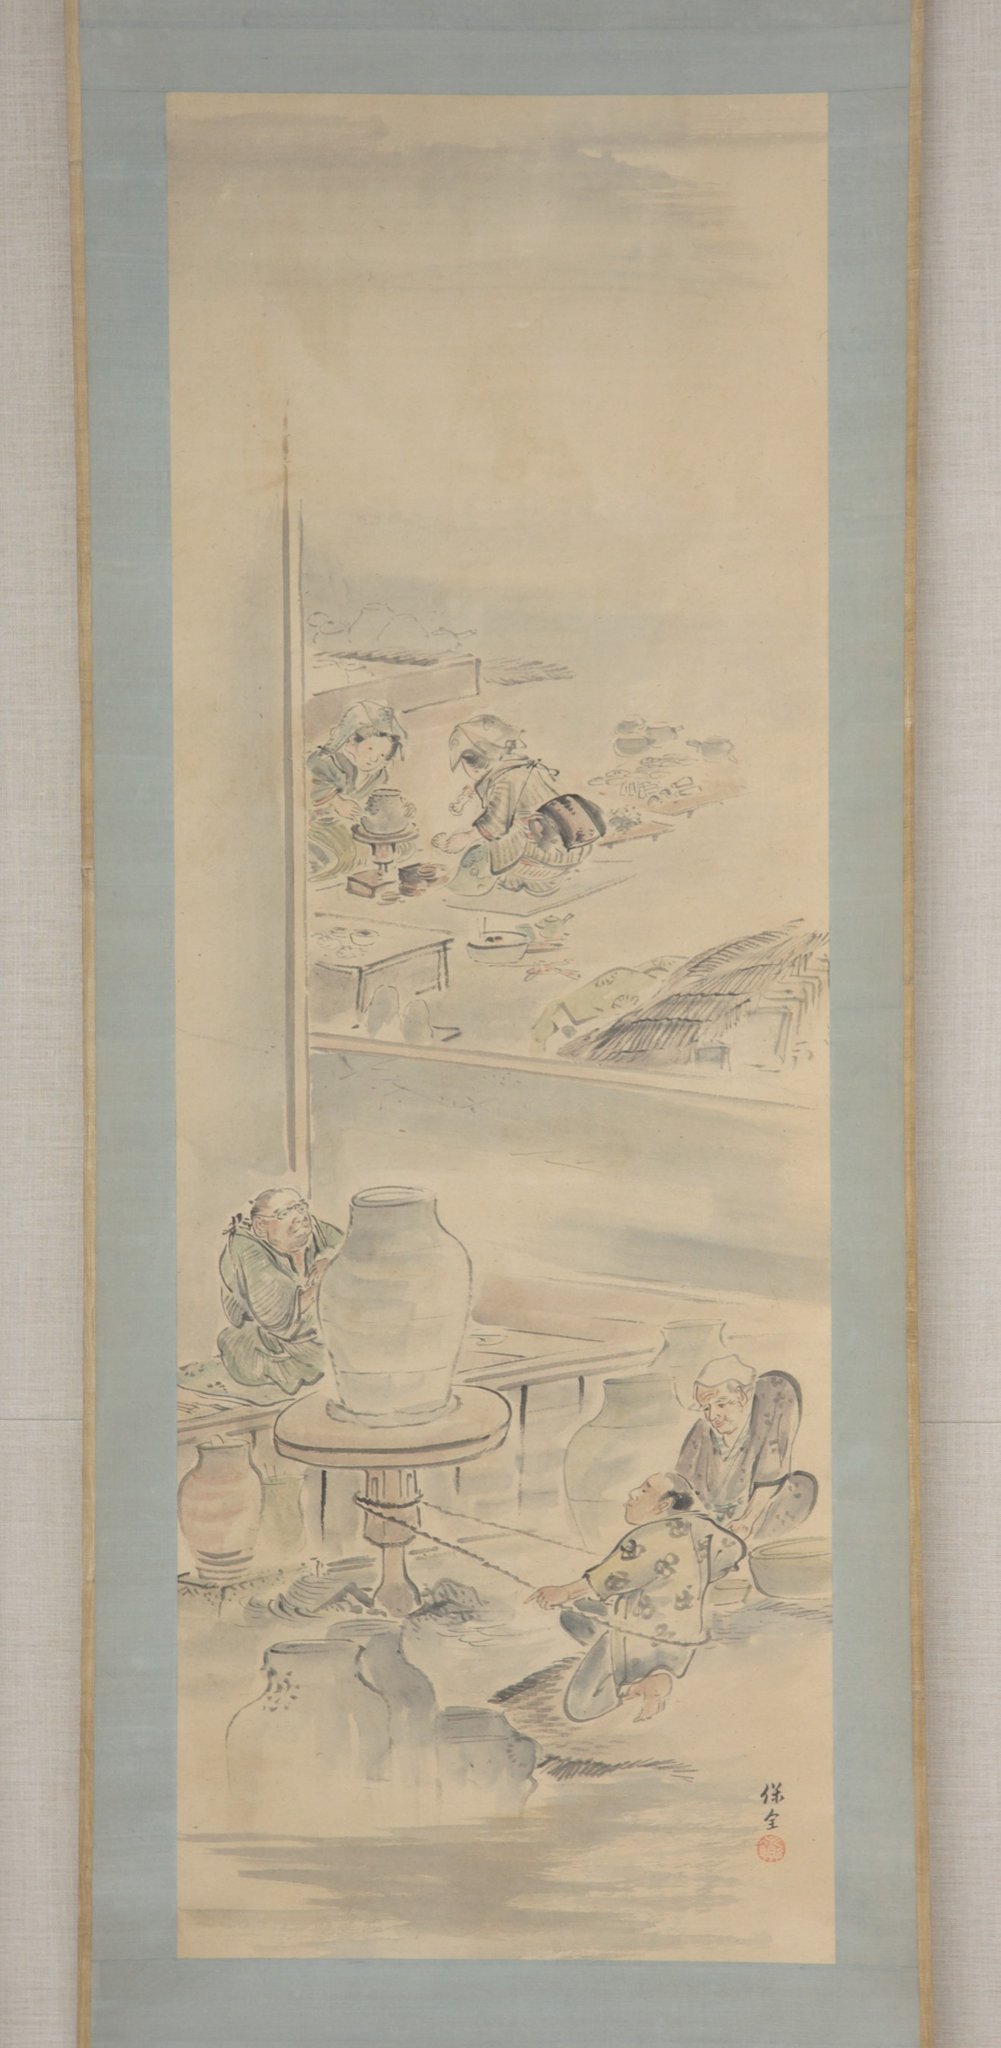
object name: hanging scroll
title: Making Ceramics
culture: japanese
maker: eiraku hozen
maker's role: artist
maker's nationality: japanese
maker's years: 1795-1854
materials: ink, paper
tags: men,working